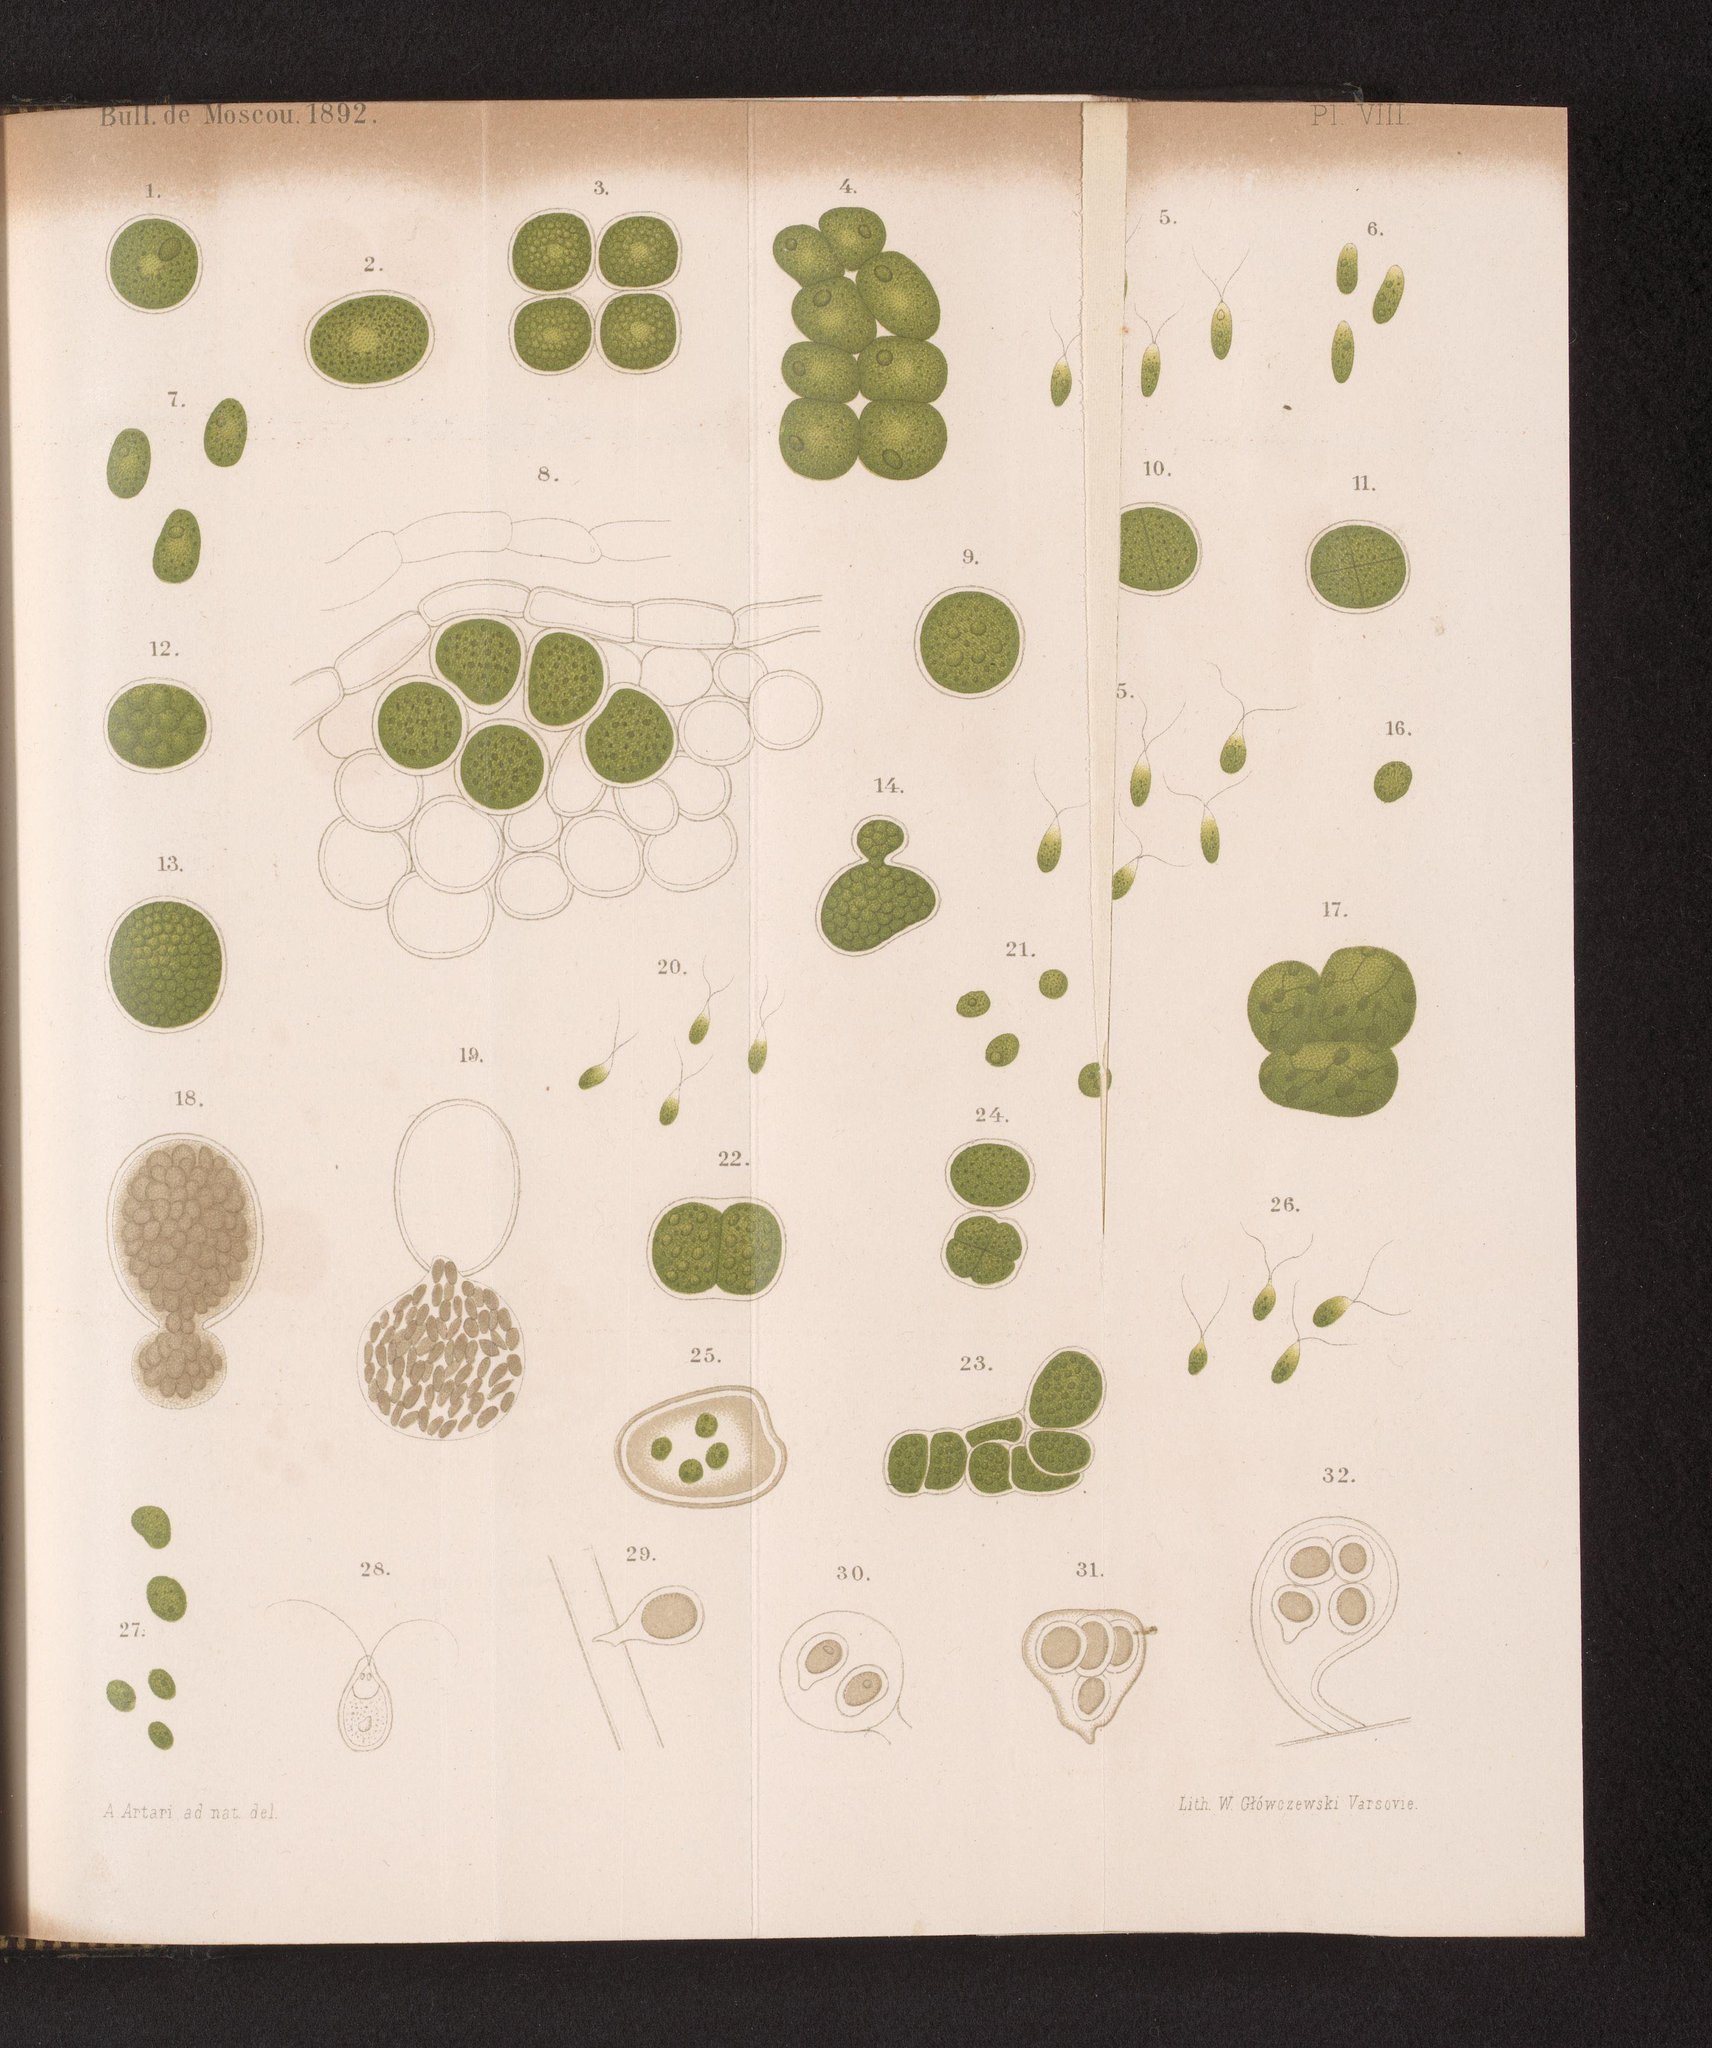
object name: photomechanical print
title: 32 voorstellingen van cellen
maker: w. glówczewski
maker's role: clichémaker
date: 1888-1893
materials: paper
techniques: lithograph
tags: biology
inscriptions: inscription: ‘A. Atari ad nat del’